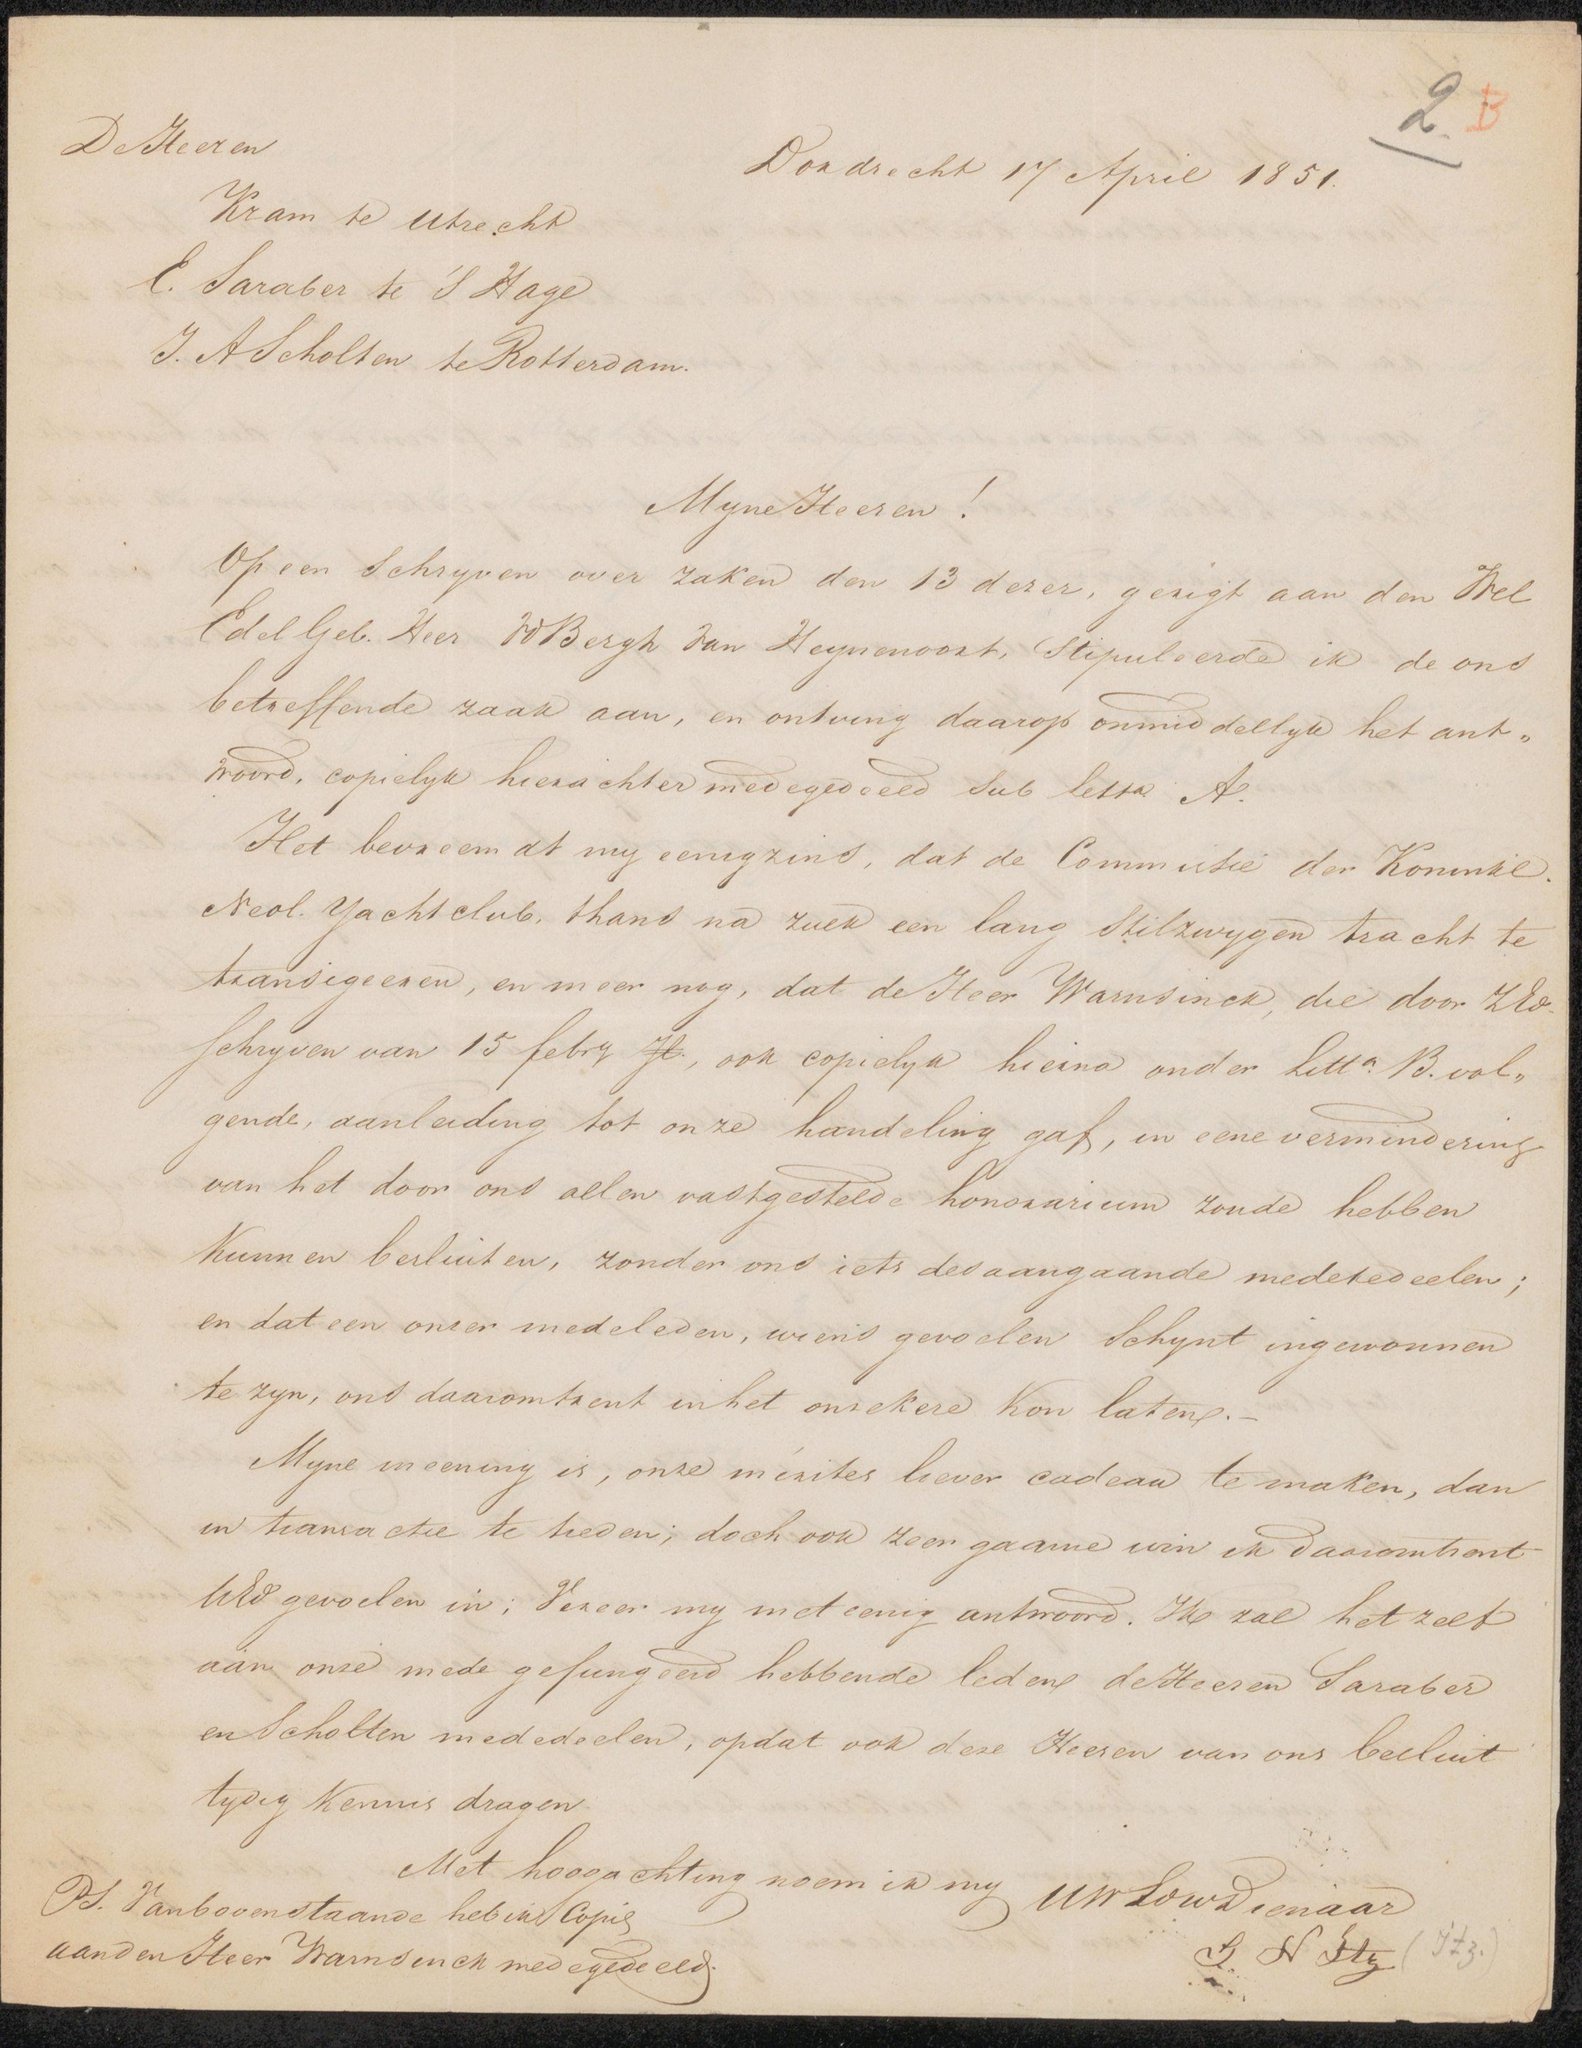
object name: letter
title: Brief aan Christiaan Kramm, Elie Saraber en J.A. Scholten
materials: ink, paper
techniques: pen, writing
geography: dordrecht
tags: the hague, utrecht, print maker, draughtsman, christiaan kramm, den bosch, dordrecht, painter, george nicolaas itz, amsterdam, isaac warnsinck, passions, emotions, affections, architecture, money, rotterdam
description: Brief bevat verso brief van Willem Samuel van den Bergh van Heinenoord aan George Nicolaas Itz.